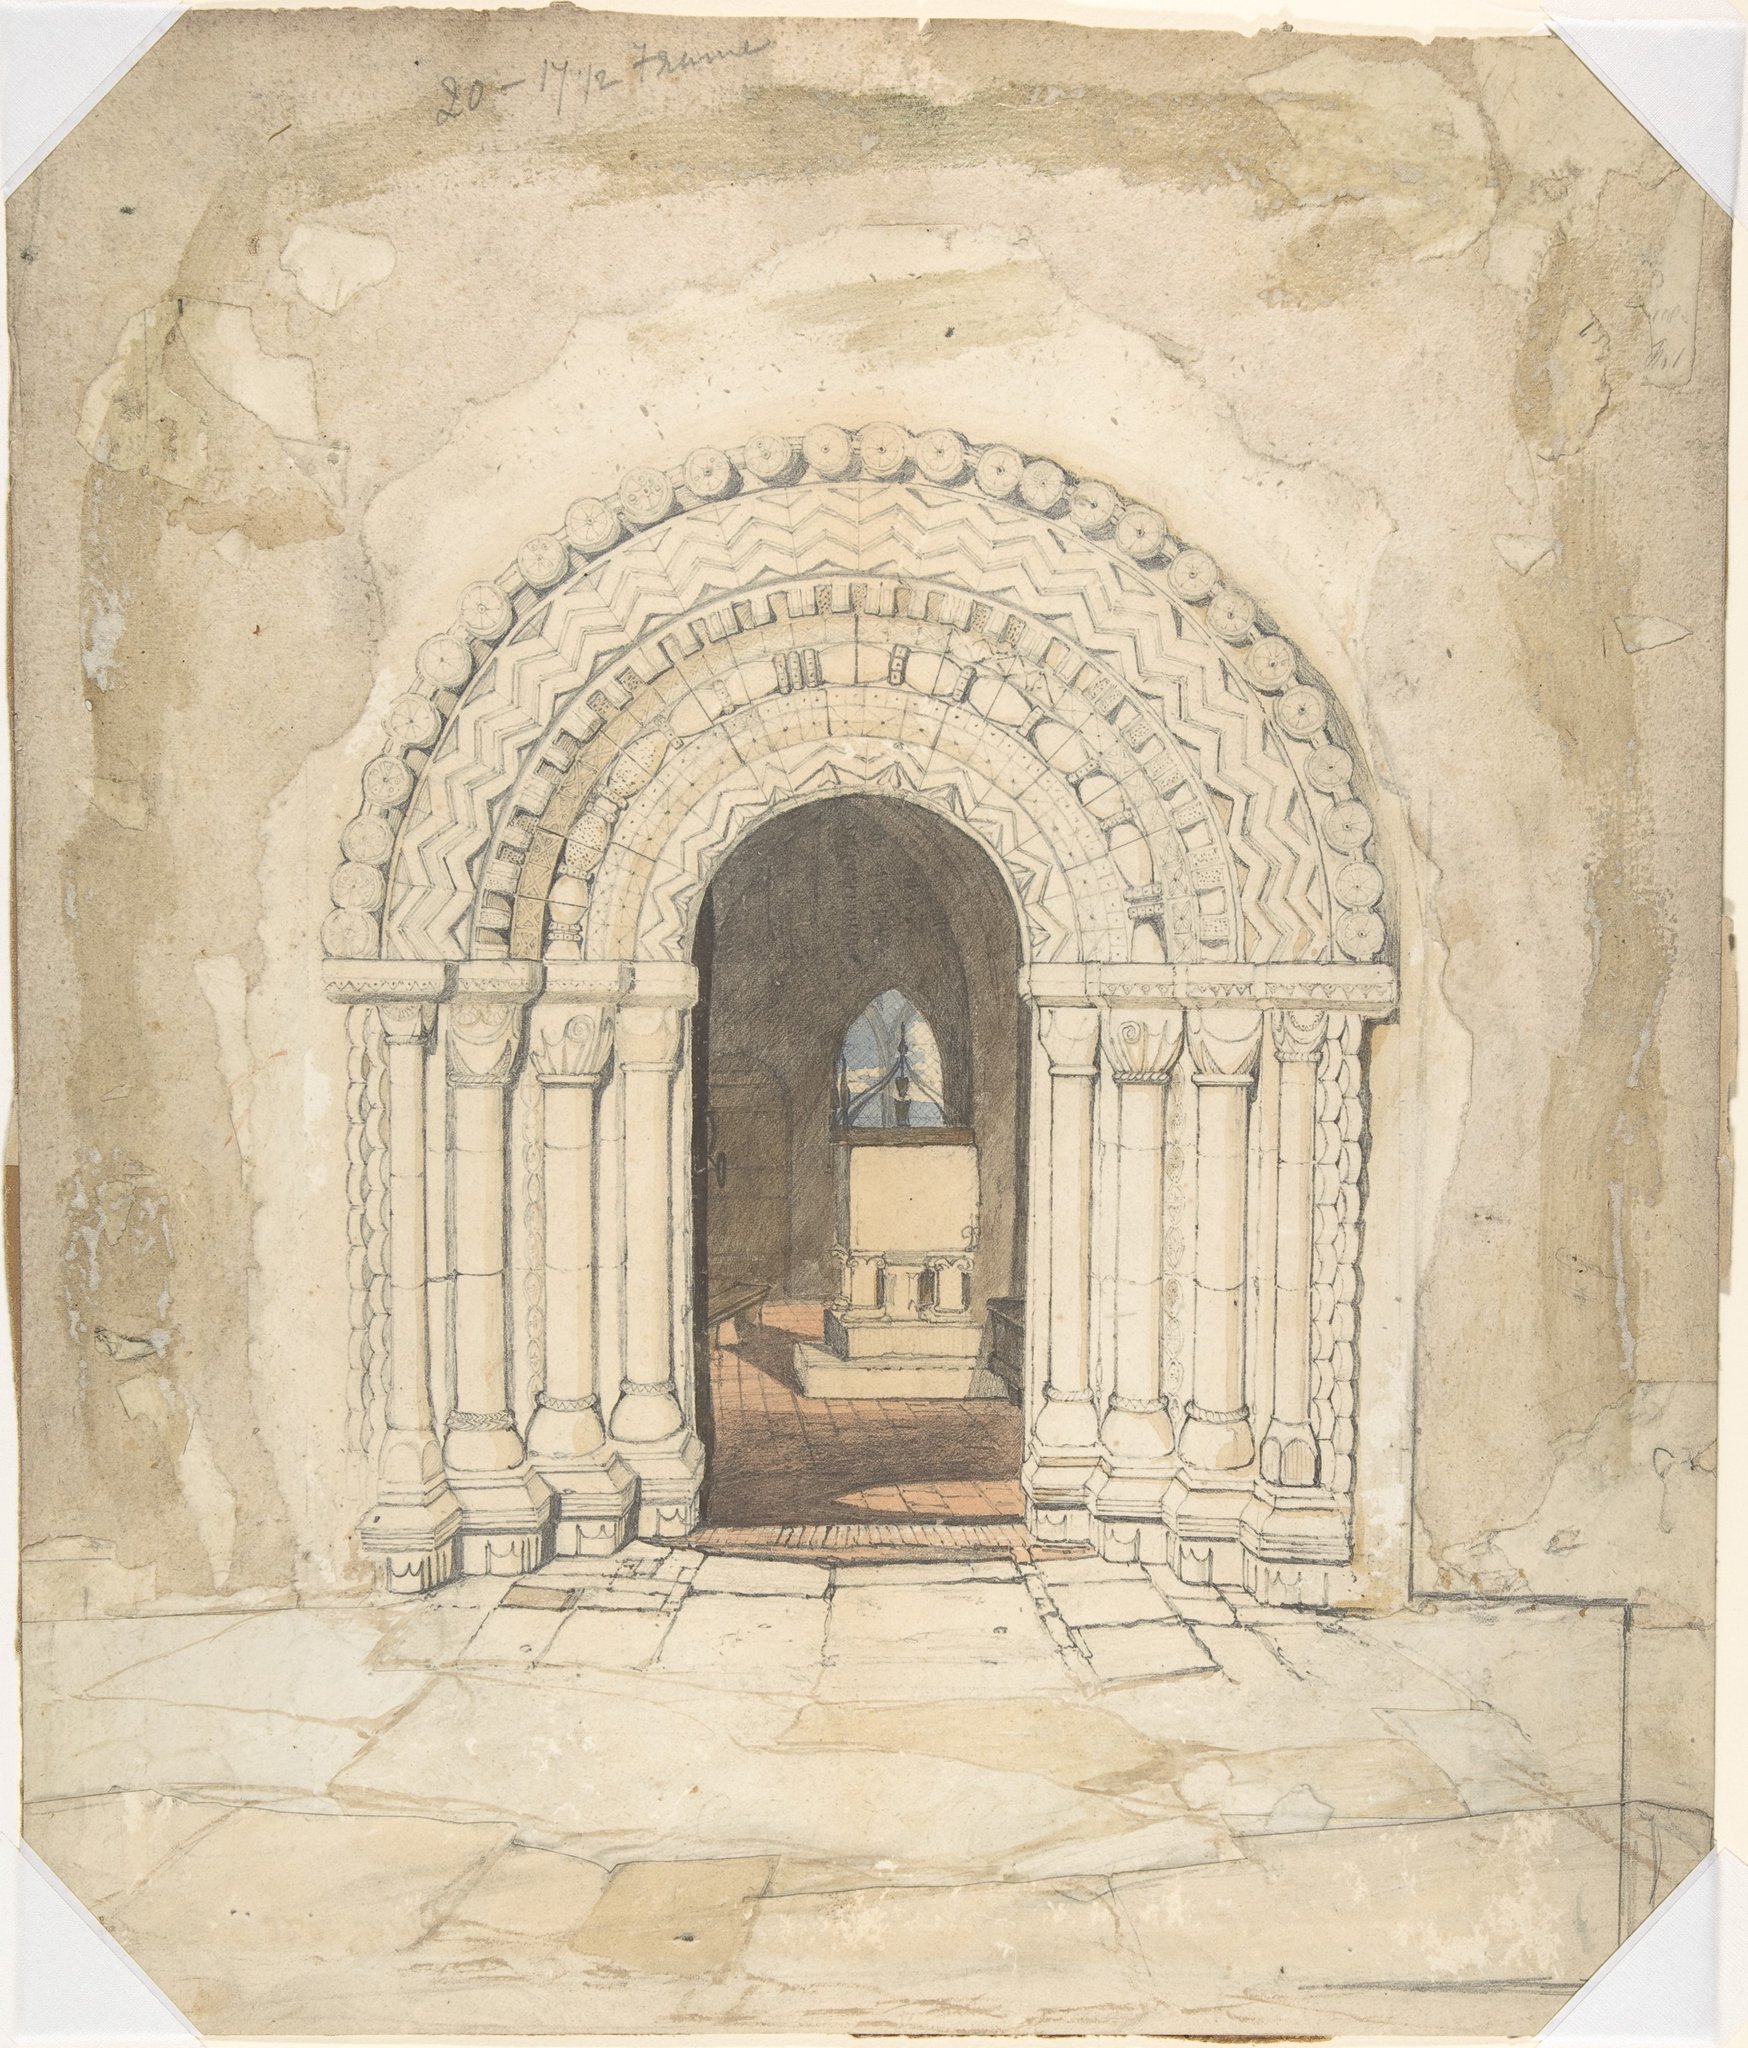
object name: drawing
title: Doorway, Heckingham Church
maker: john sell cotman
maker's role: artist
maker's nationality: british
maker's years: 1782-1842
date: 1818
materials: graphite, watercolor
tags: architecture,doorways,churches